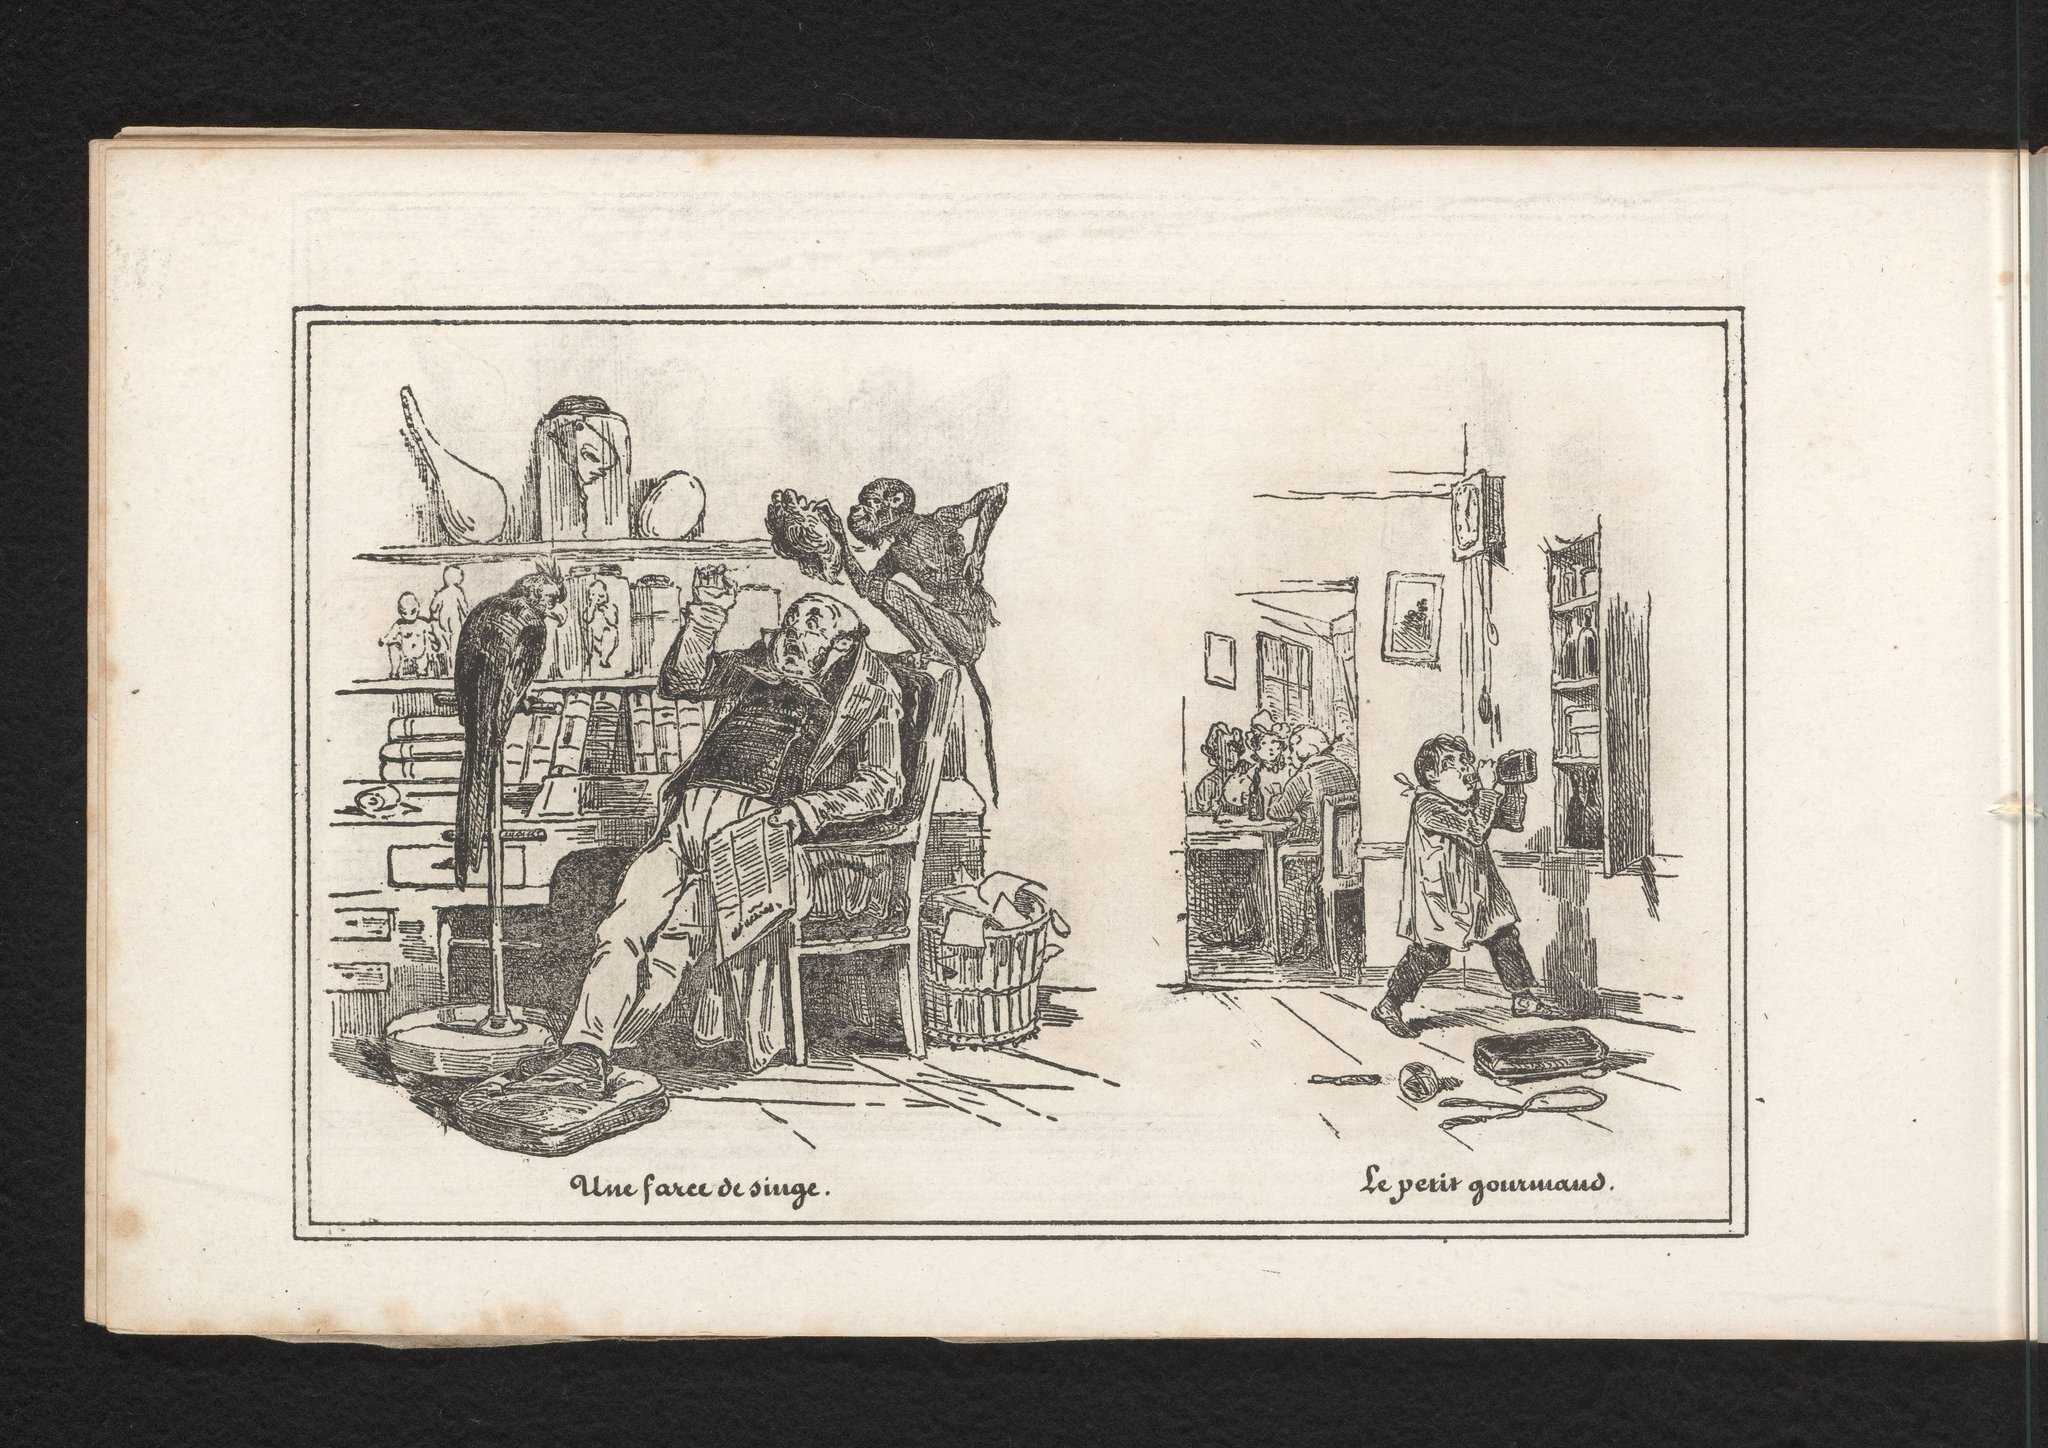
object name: print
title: Kleine verzameling van prenten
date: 1834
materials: paper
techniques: engraving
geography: paris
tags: monkeys, apes, gluttony, intemperance, 'gula'; 'gola', 'ingordigia', 'ingordigia overo avidità', 'voracità' (ripa) ~ personification of one of the seven deadly sins, wig, glutton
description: Blad met twee afzonderlijke voorstellingen. Deze prent maakt deel uit van een album.